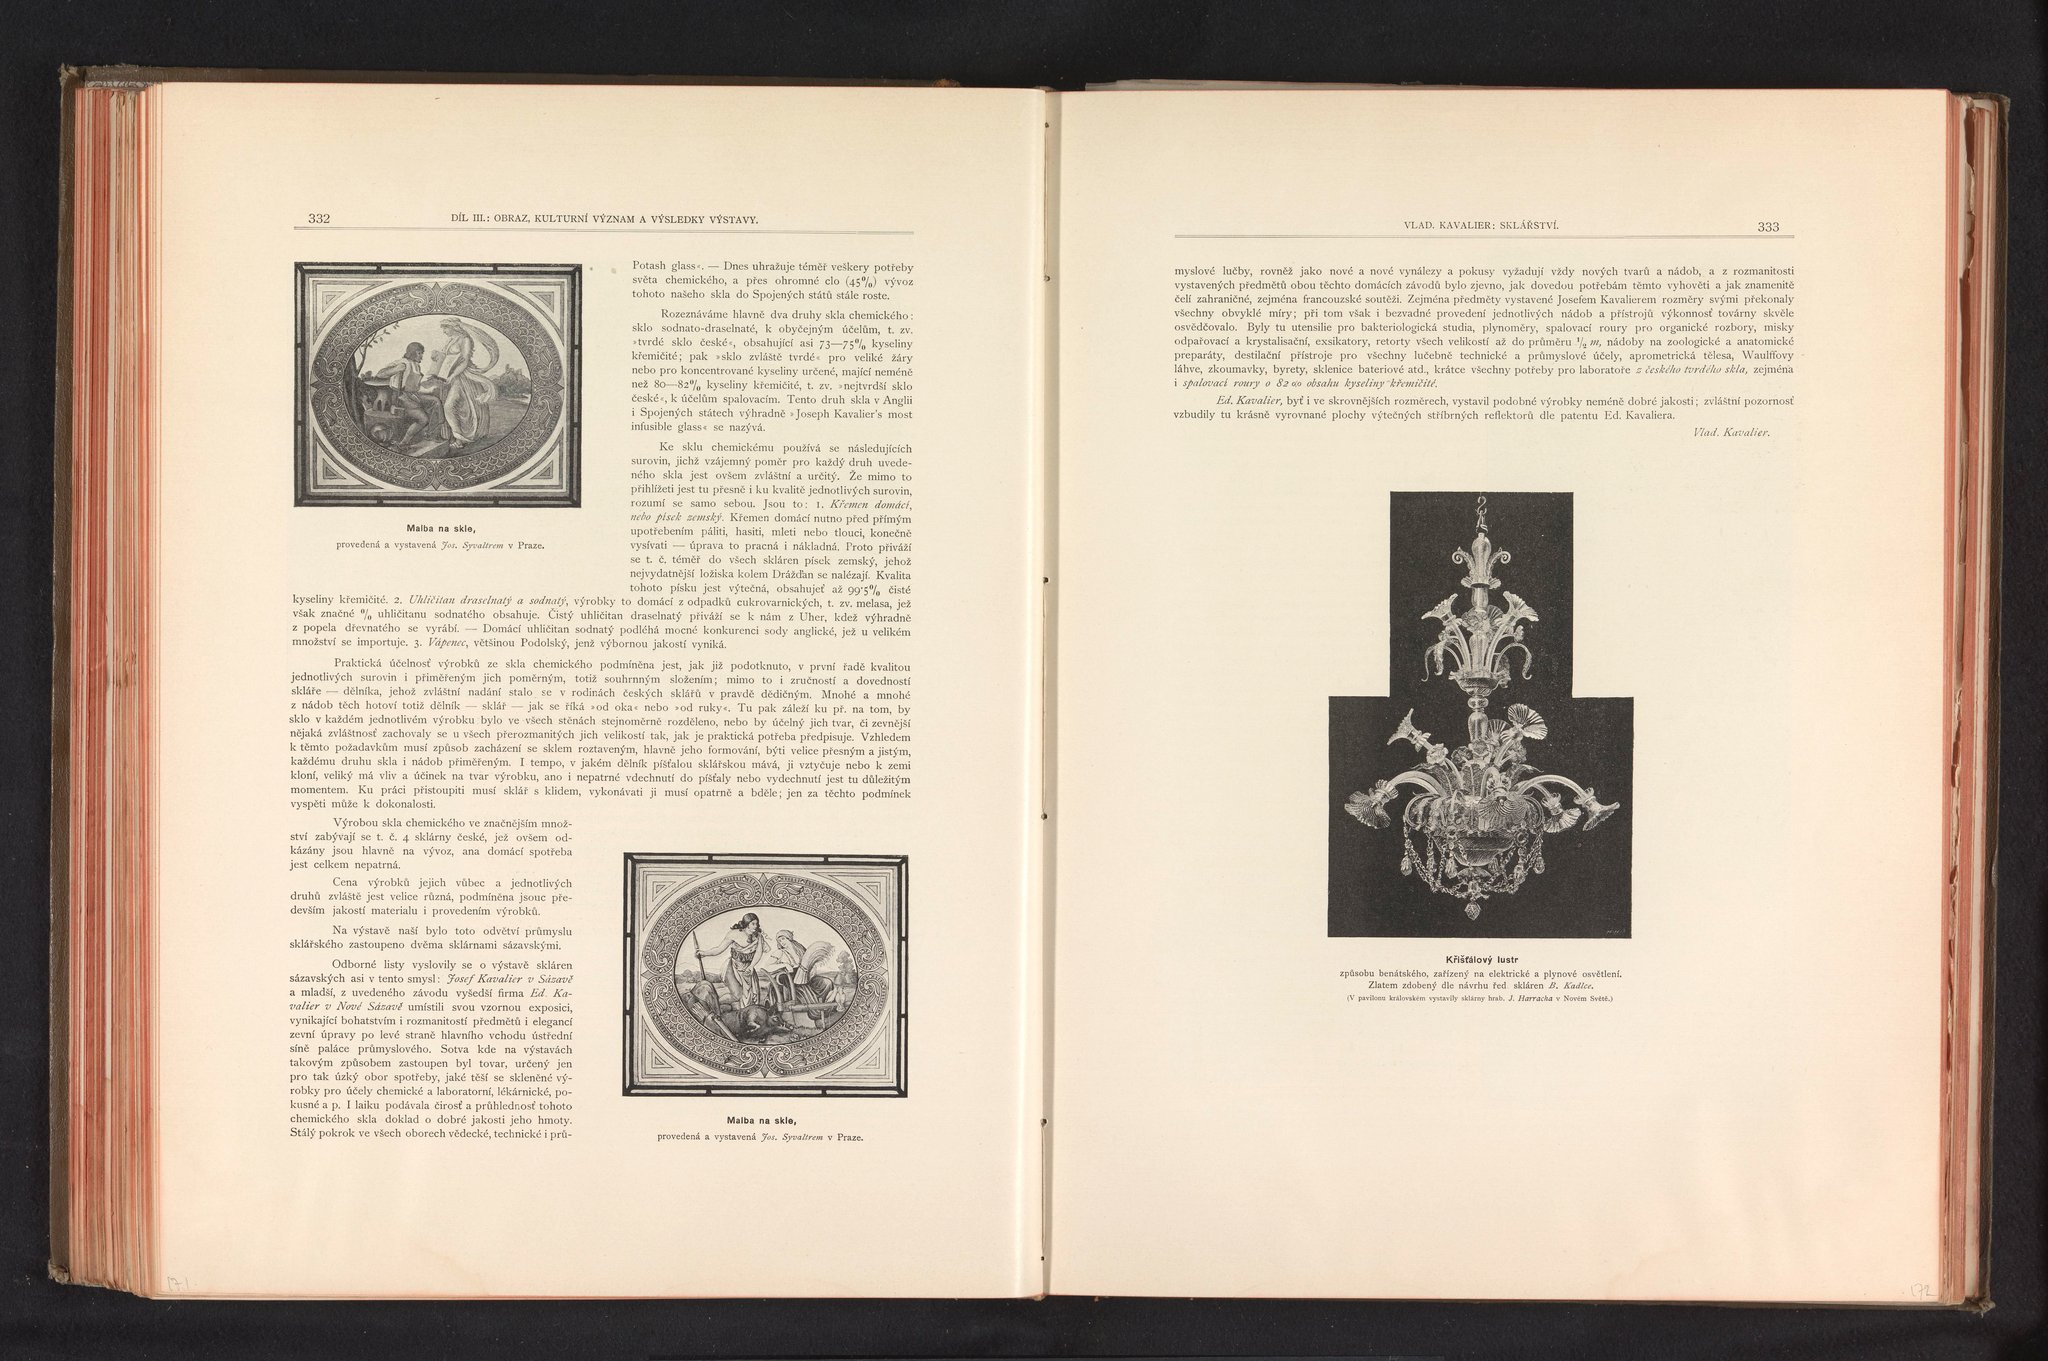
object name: page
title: Twee fotoreproducties van schilderijen, voorstellende een vrouw toont een man een geschrift en een jager naast een boerin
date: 1890-1895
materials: paper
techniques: autotype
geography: prague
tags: hunter, farmers - aa - female farmer, farmer's wife